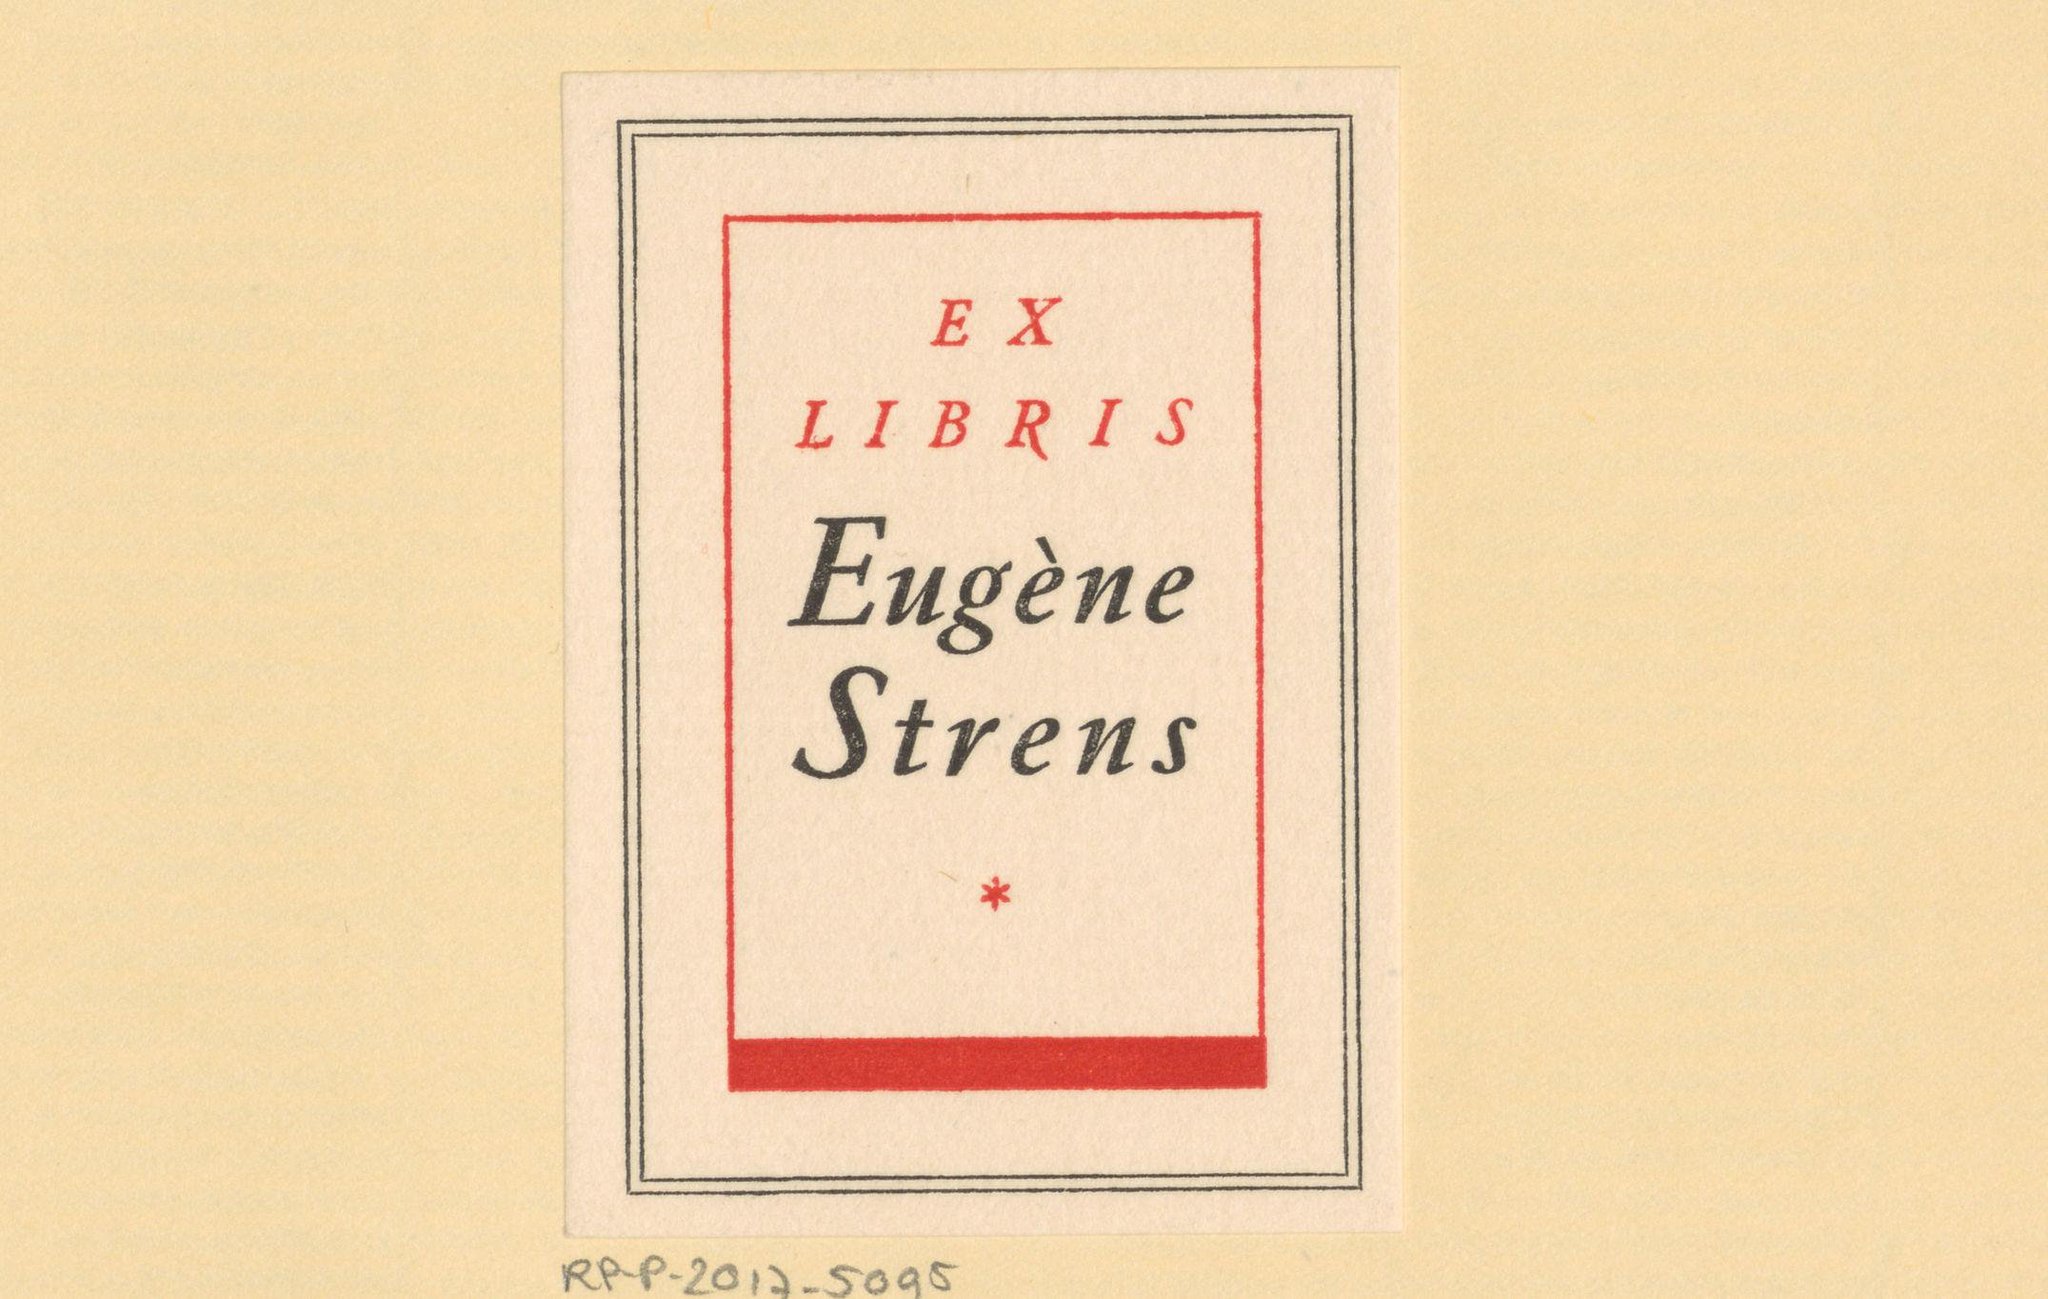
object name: bookplate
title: Ex libris van Eugène Strens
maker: Anonymous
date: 1930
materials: paper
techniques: printing block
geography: netherlands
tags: engineer, eugène louis charles marie strens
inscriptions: inscription: ‘Joh. Enschede & Zn. 1930 / Str. 8.’